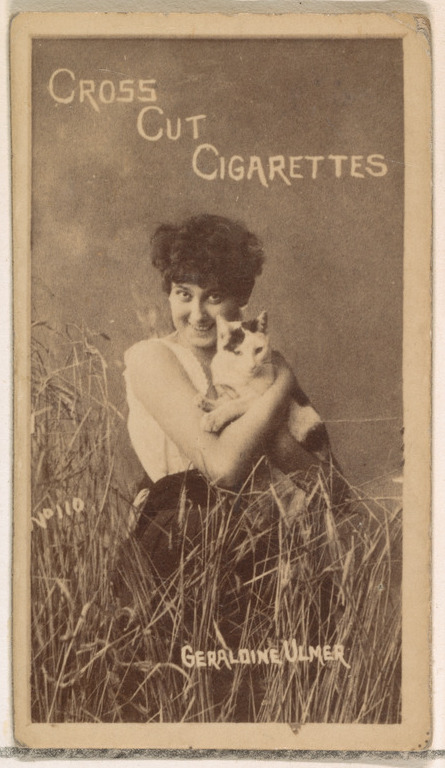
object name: print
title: Card Number 110, Geraldine Ulmer, from the Actors and Actresses series (N145-1) issued by Duke Sons & Co. to promote Cross Cut Cigarettes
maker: w. duke, sons & co.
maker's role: publisher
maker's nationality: american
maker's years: 1870-1920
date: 1880-1889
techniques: albumen silver print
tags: portraits,women,cats,actresses